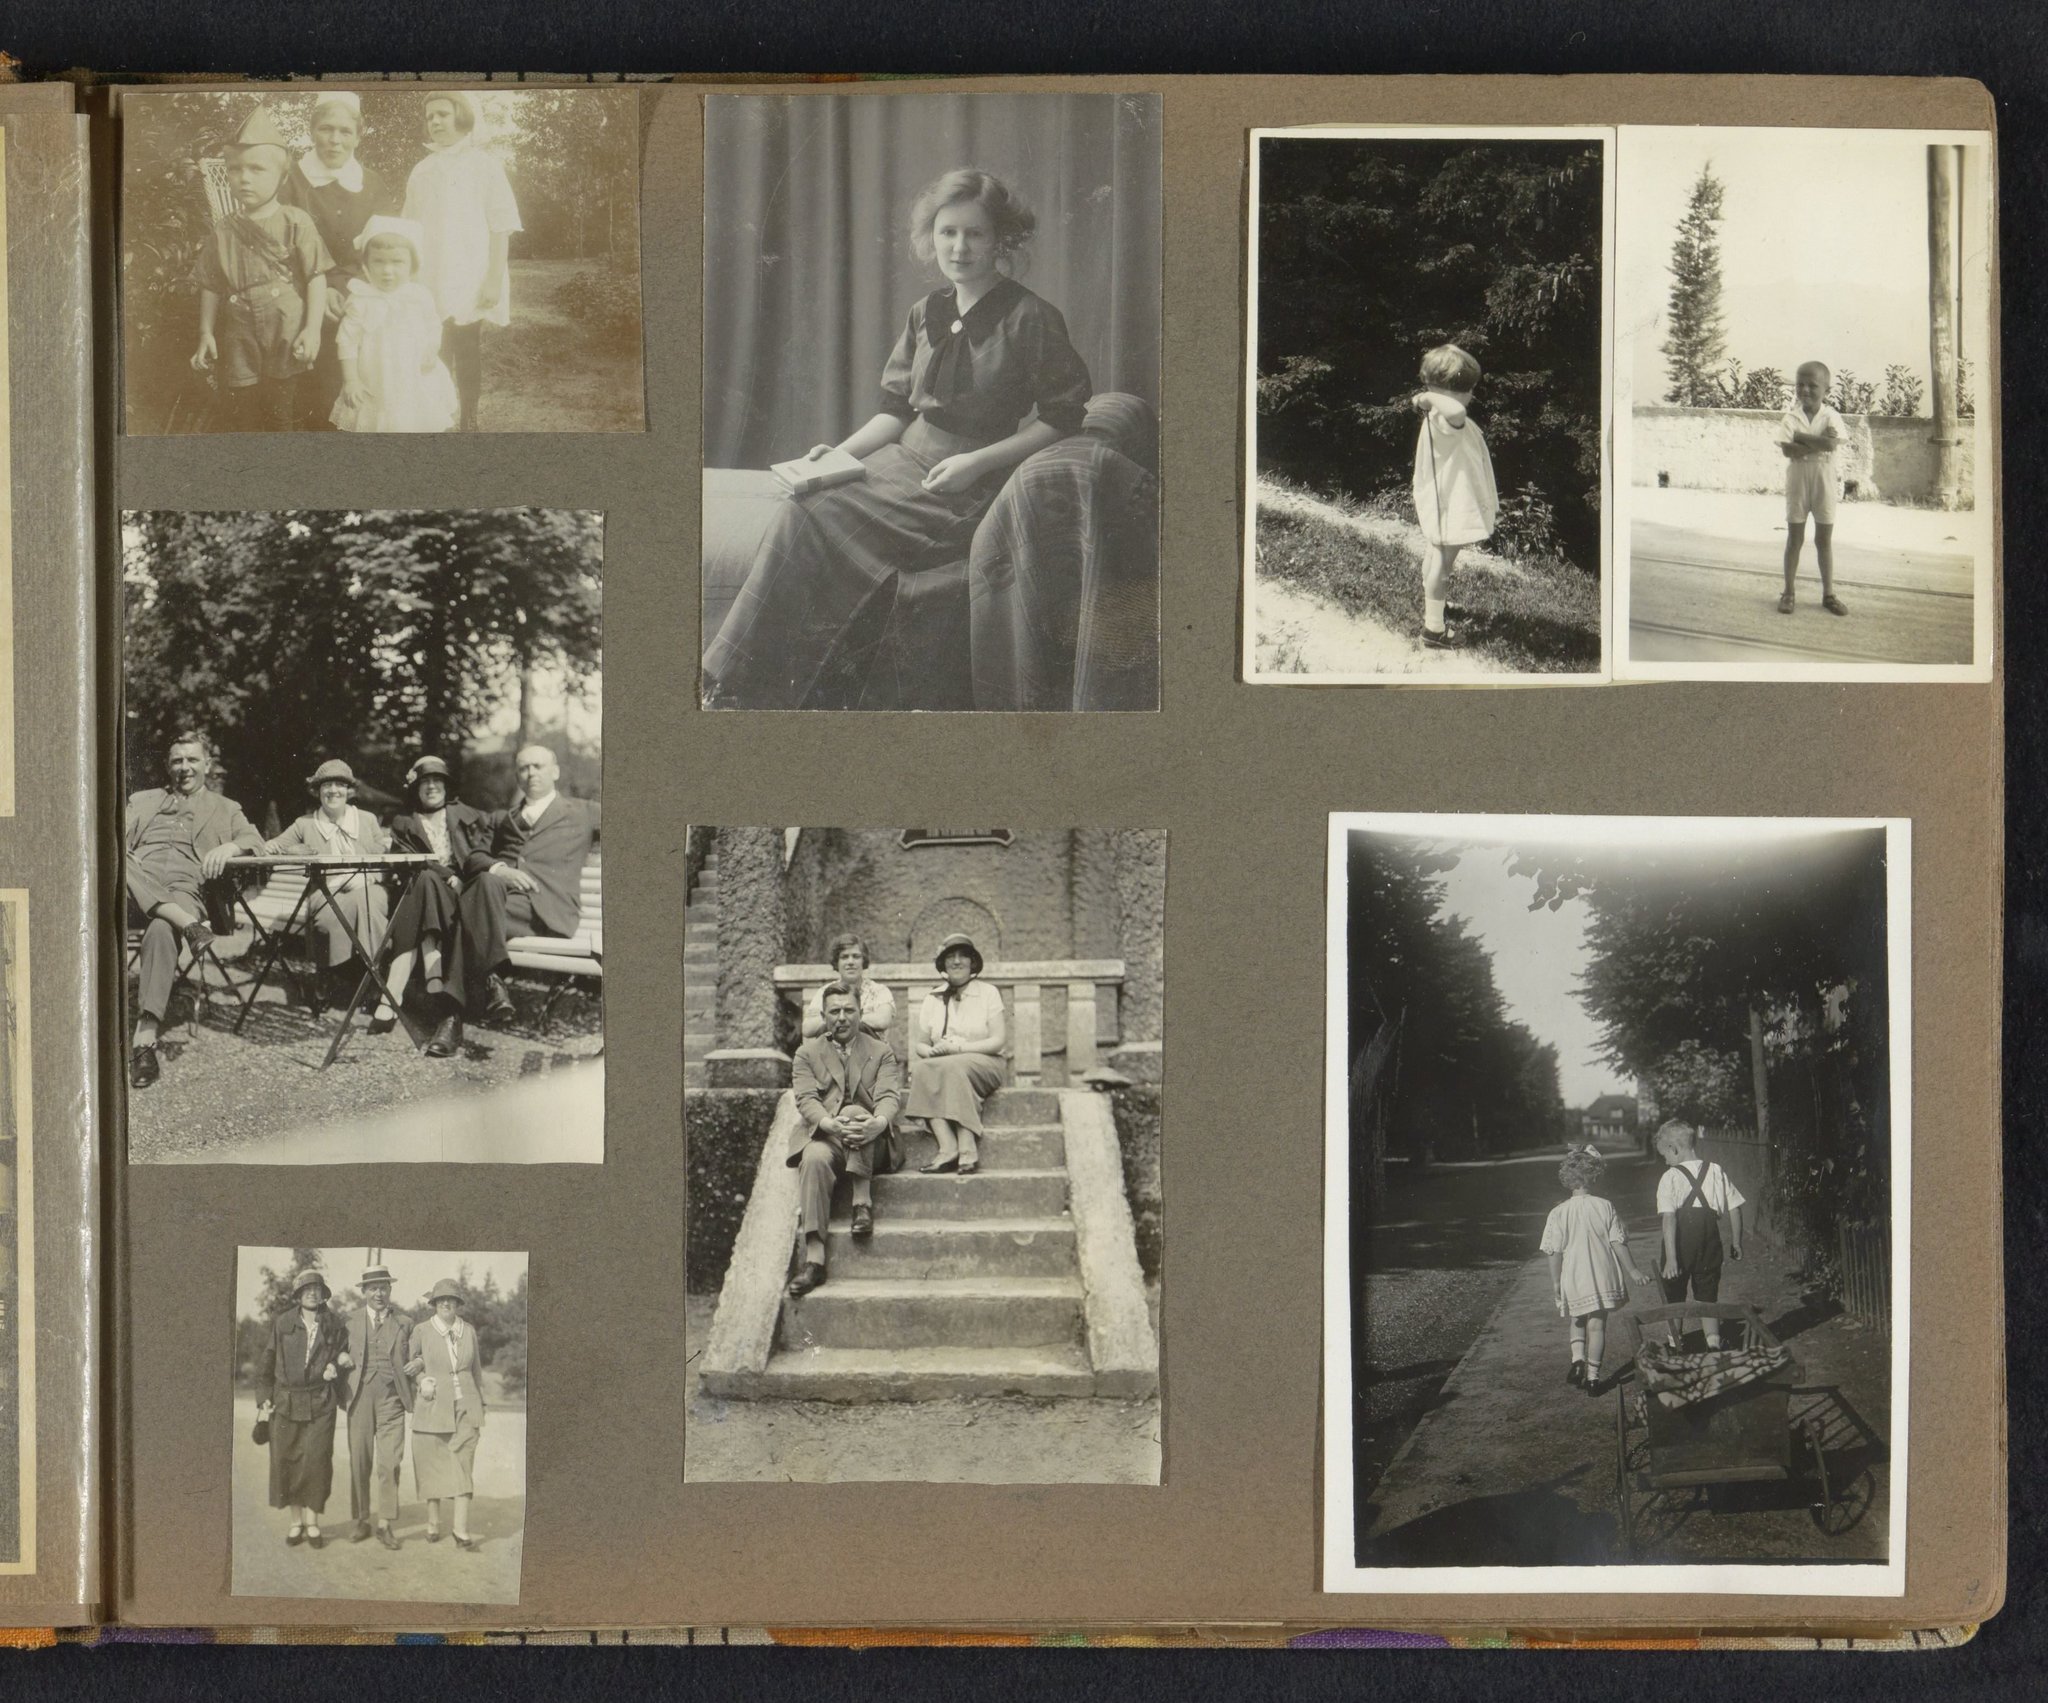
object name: photograph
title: Gezelschappen en kinderen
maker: Anonymous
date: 1900-1925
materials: cardboard, photographic support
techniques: gelatin silver print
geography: netherlands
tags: adult woman, adult man, child, (playing with) barrow, wagon, netherlands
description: Albumblad met foto's van een gezelschap, mogelijk tijdens een uitstapje en een portret van een zittende vrouw met boek. Ook foto's van kinderen, onder meer een bolderkar voorttrekkend. Onderdeel van Fotoalbum van een onbekende Nederlandse familie met connecties in Suriname en Nederlands-Indië (2).